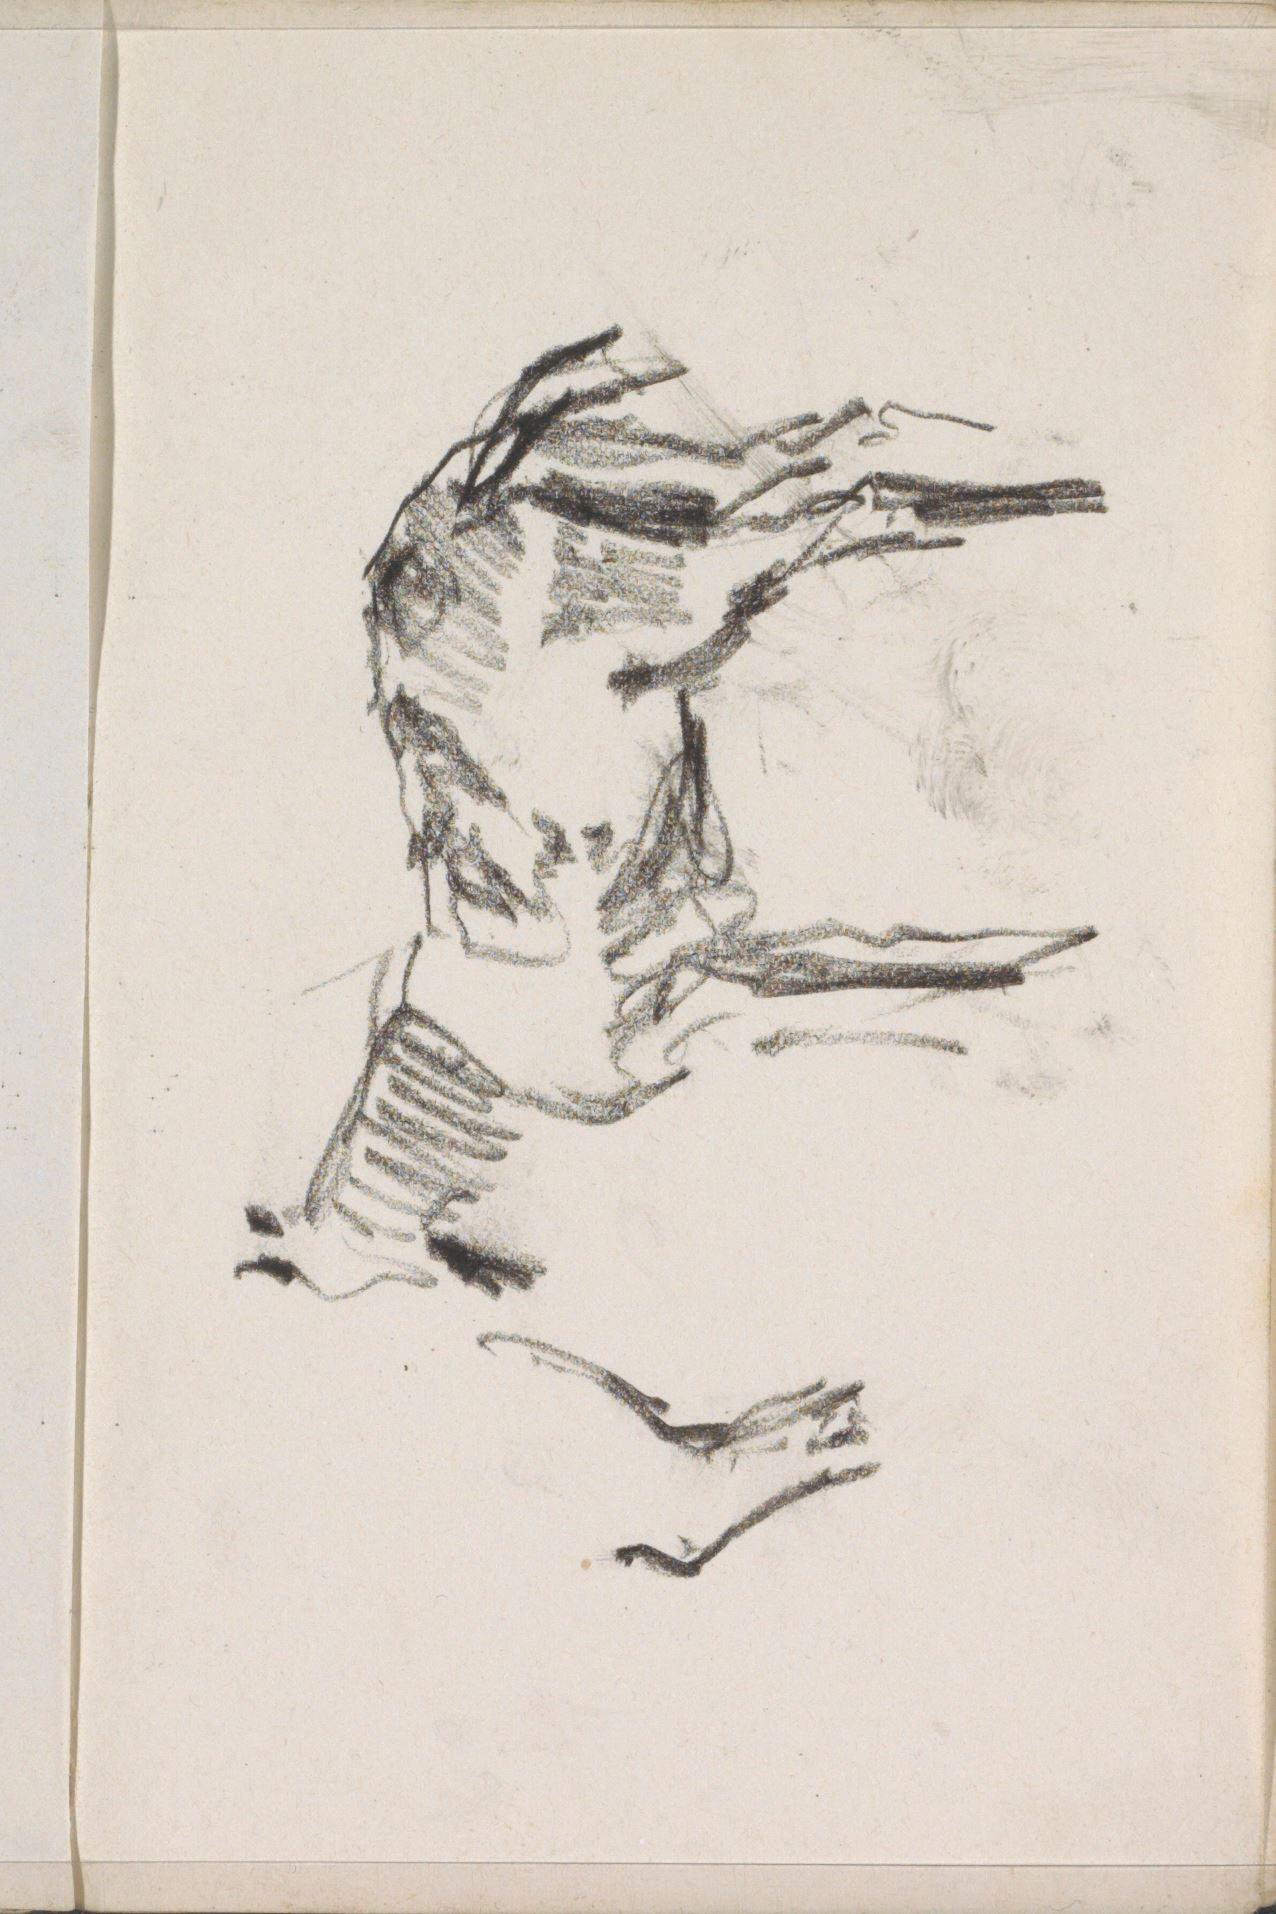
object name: sketchbook leaf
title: Paard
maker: george hendrik breitner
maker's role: draughtsman, painter, print maker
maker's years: 1857-1923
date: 1917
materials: chalk, paper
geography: amsterdam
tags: horse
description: Pagina 32 uit een schetsboek met 44 bladen.